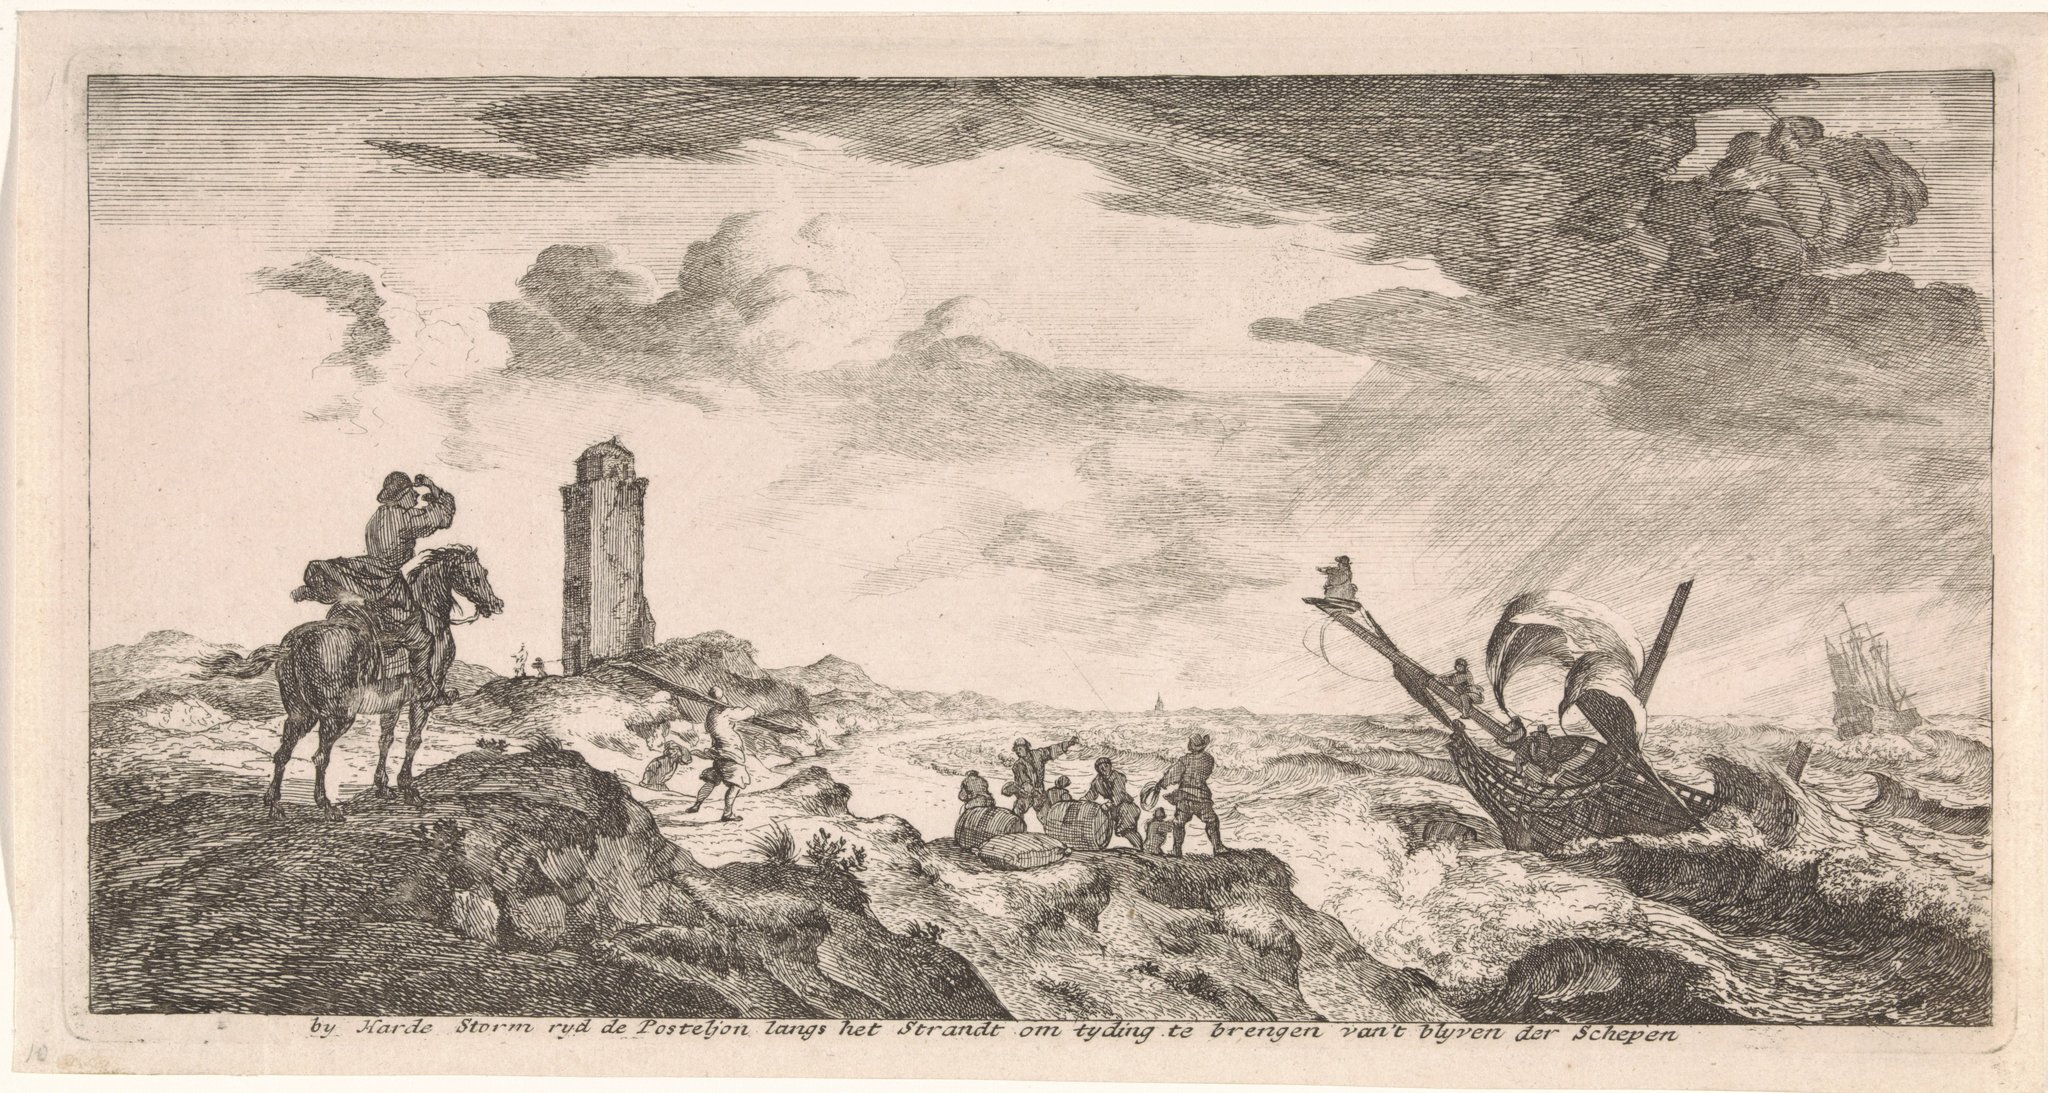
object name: print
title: Postkaart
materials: paper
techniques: engraving, etching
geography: rotterdam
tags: postal service, shipwreck, ships (in general) - cc - more than one ship, storm at sea, sea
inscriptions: collector's mark: Lugt 2228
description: Op de voorgrond kijkt een postbode te paard naar een storm op zee. Een schip vergaat in de woeste golven. De prent heeft een Nederlands onderschrift met uitleg.